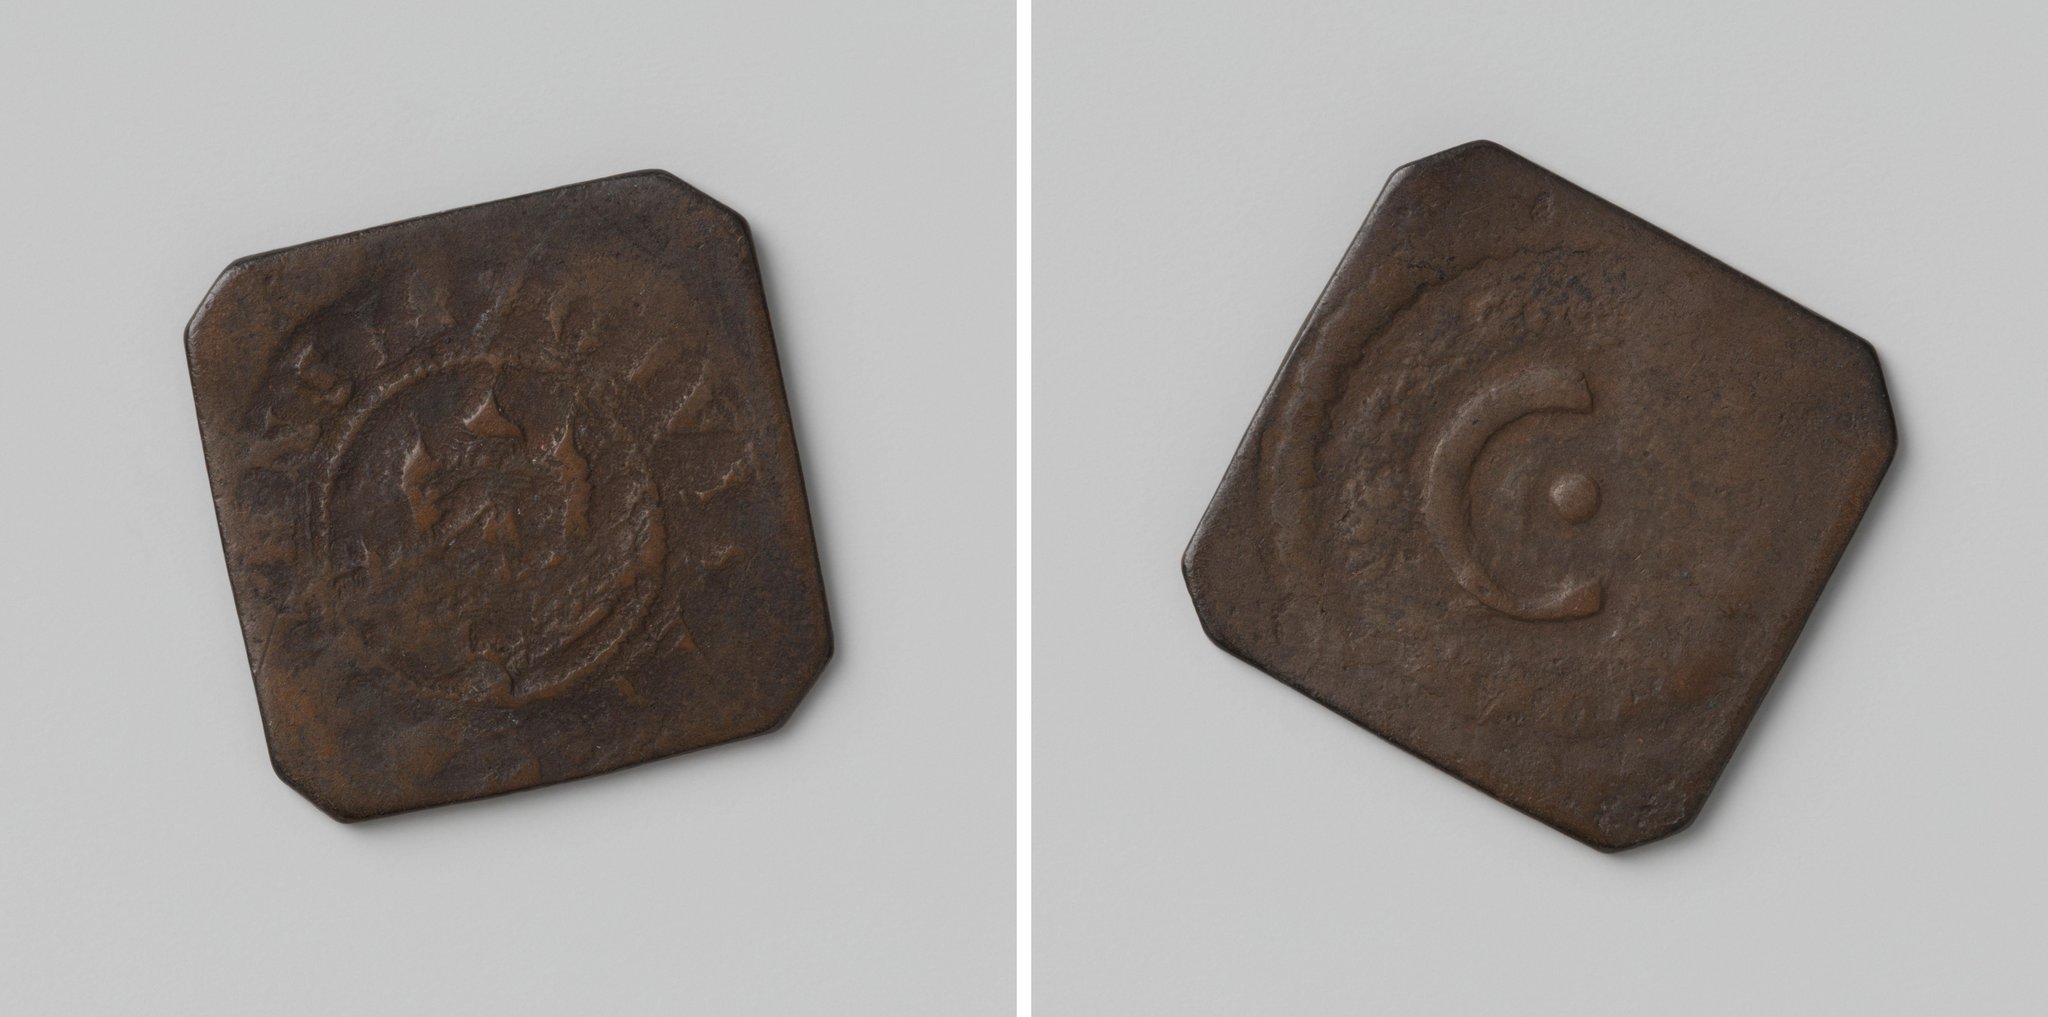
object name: bread token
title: Stad Kampen, loodje dat bij uitdeling recht gaf op brood of graan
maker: Anonymous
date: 1600-1800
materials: copper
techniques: striking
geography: kampen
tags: kampen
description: Koperen vierkant loodje met afgeschuinde hoeken. Voorzijde: in ronde stempel: burcht binnen omschrift. Keerzijde: letter C met punt erin binnen sierrand